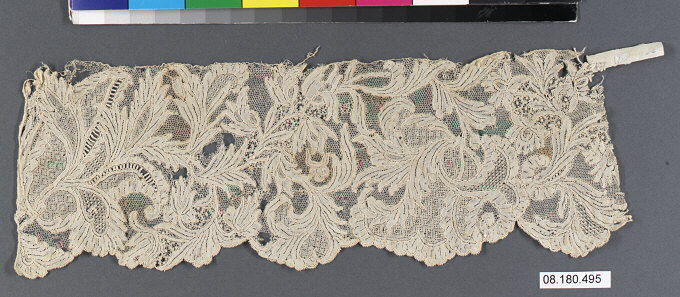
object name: fragment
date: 1701-1800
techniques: lace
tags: leaves